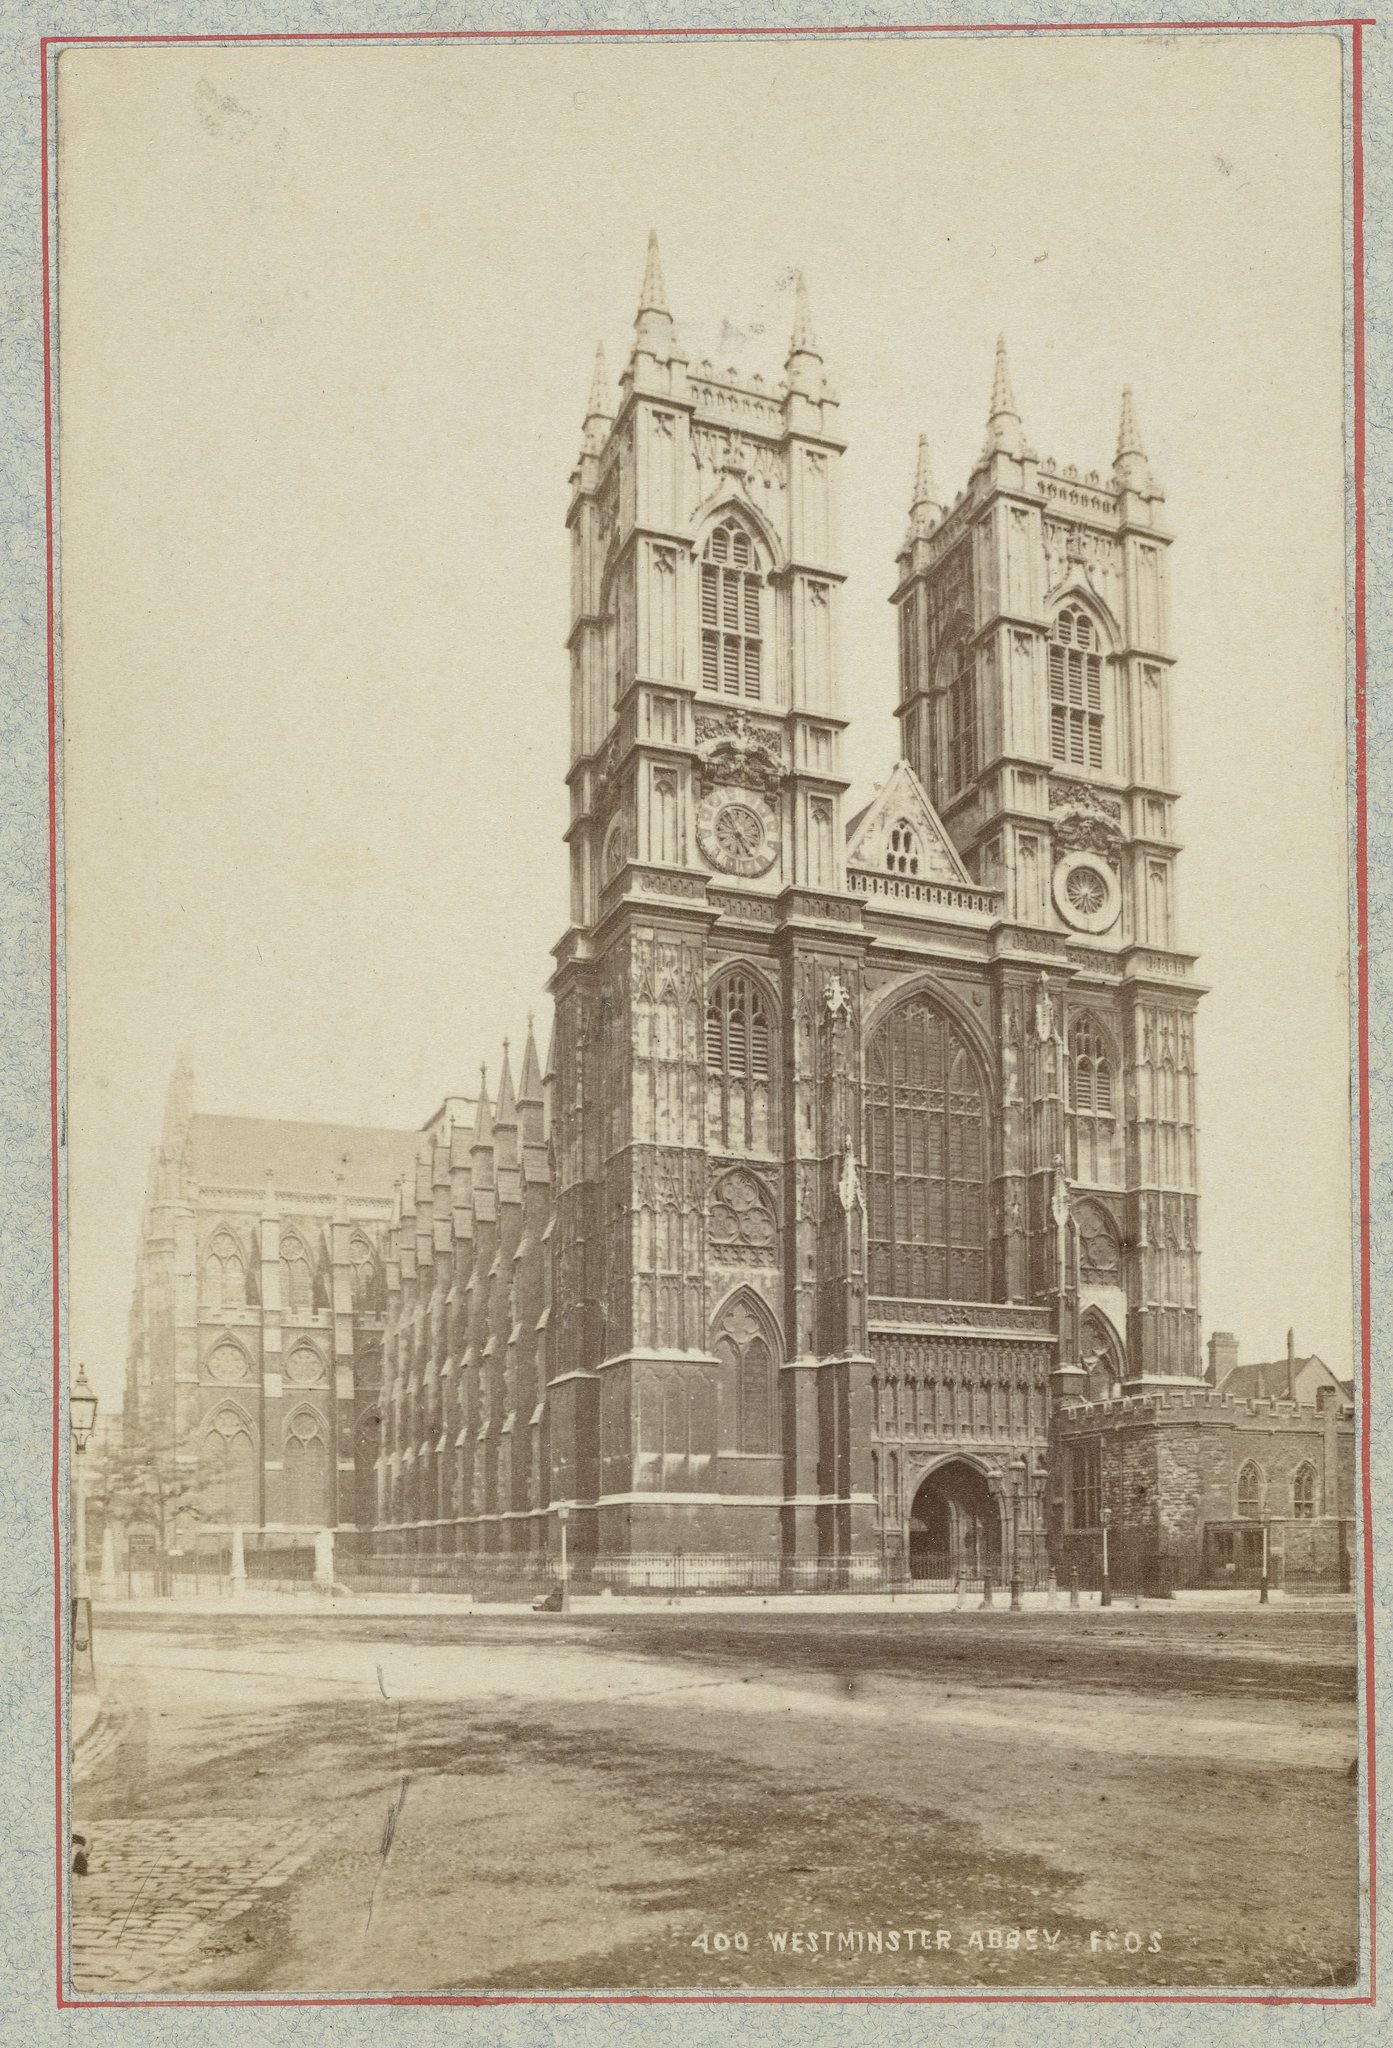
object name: photograph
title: Westminster Abbey in Londen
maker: francis godolphin osbourne stuart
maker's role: fotograaf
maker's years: 1843-1923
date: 1870-1881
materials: cardboard, paper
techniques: albumen print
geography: london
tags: church (exterior), westminster abbey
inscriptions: inscription: ‘400 FGOS’